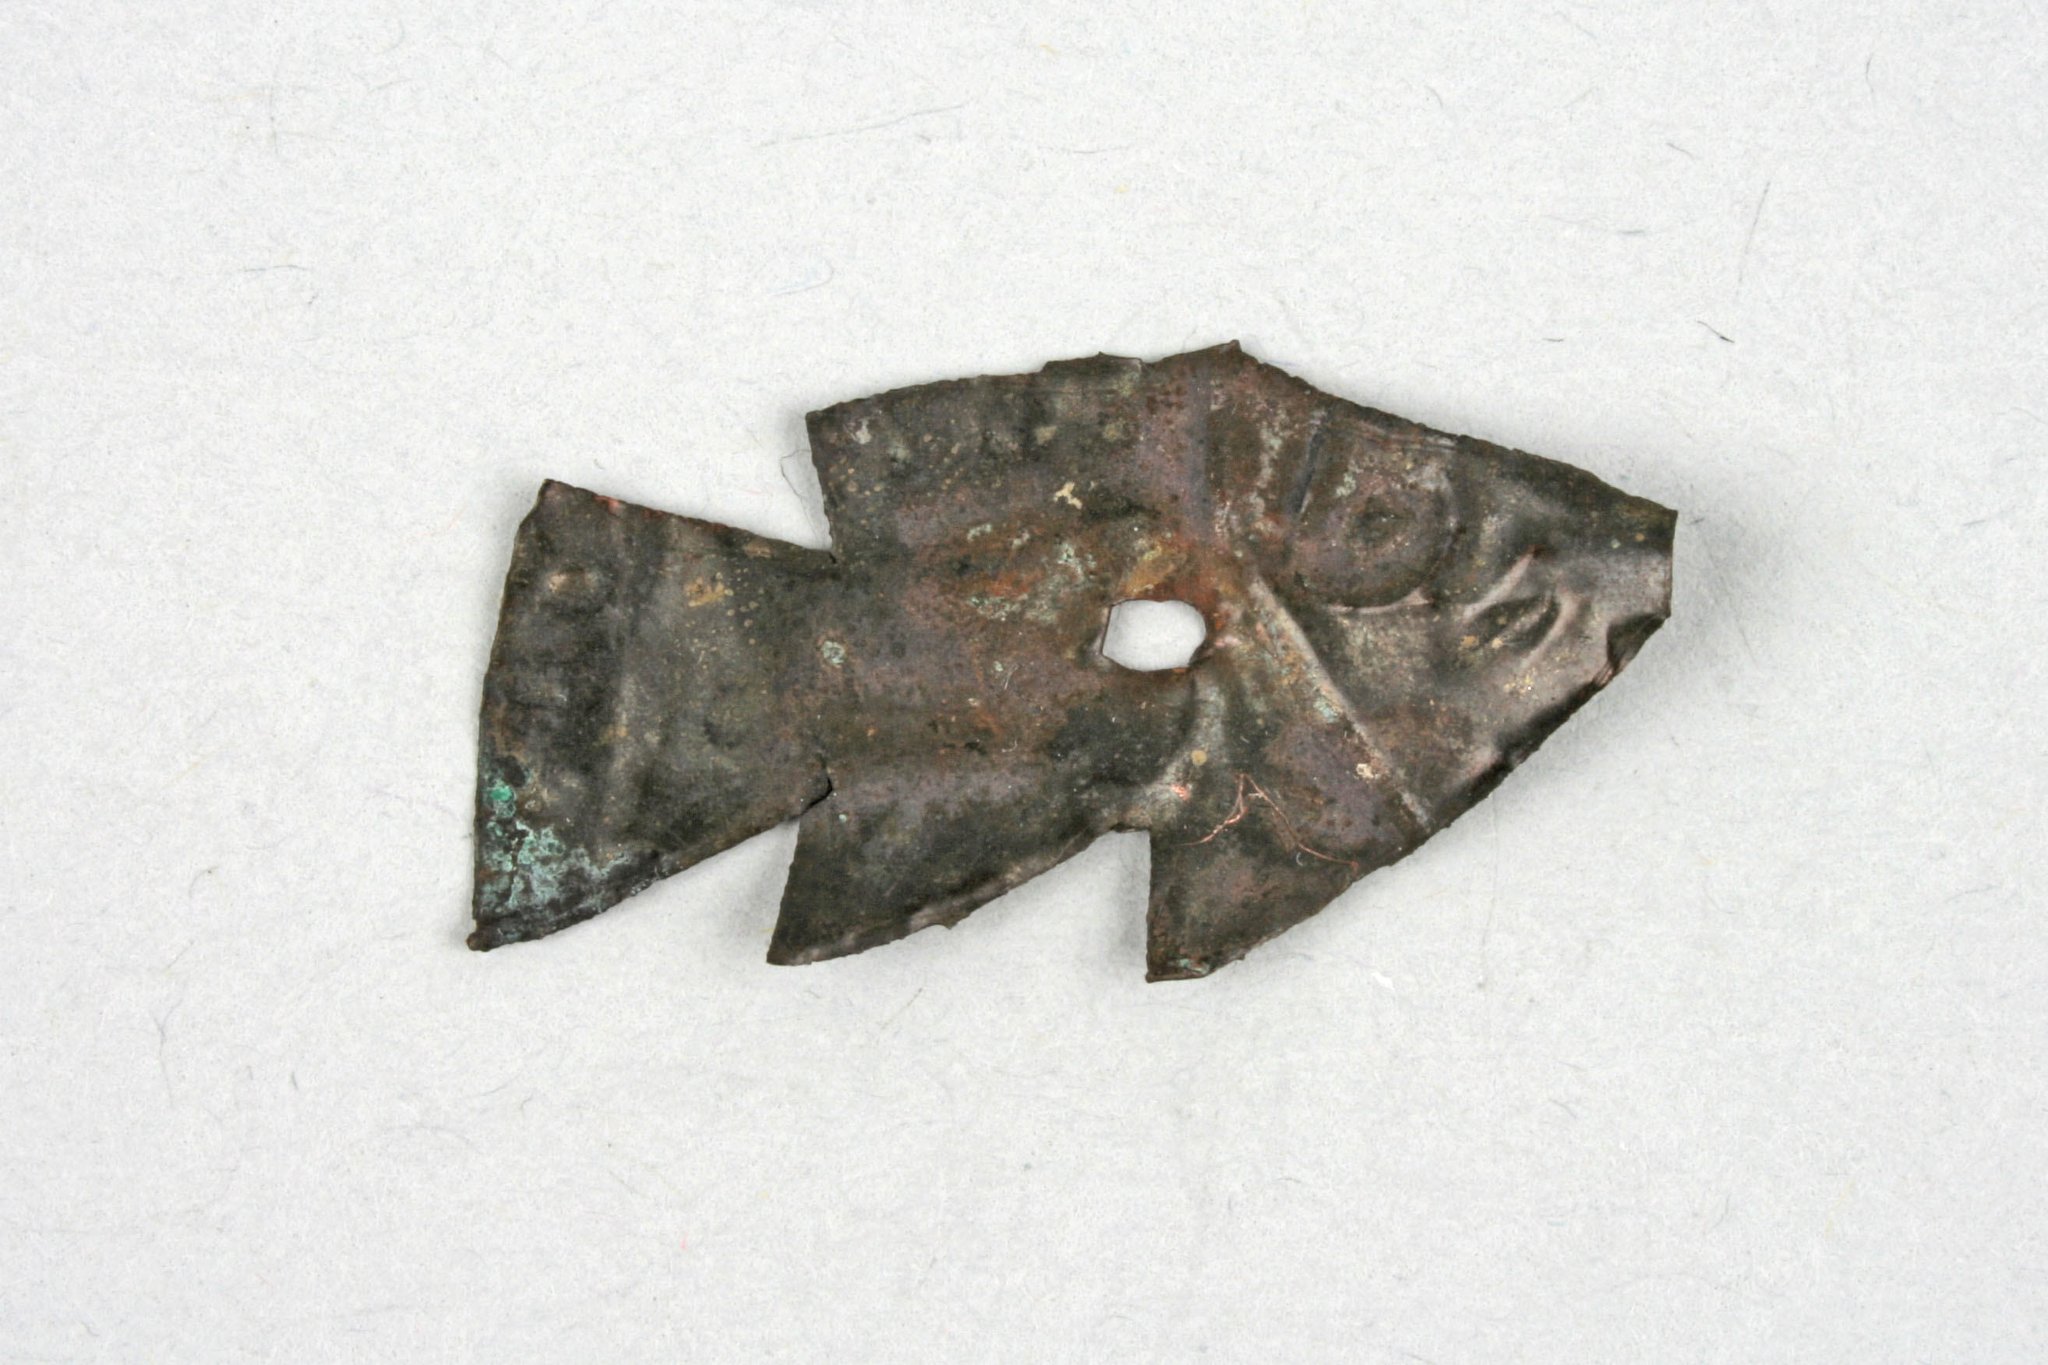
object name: costume ornament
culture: central coast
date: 1001-1200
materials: silver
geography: peru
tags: fish